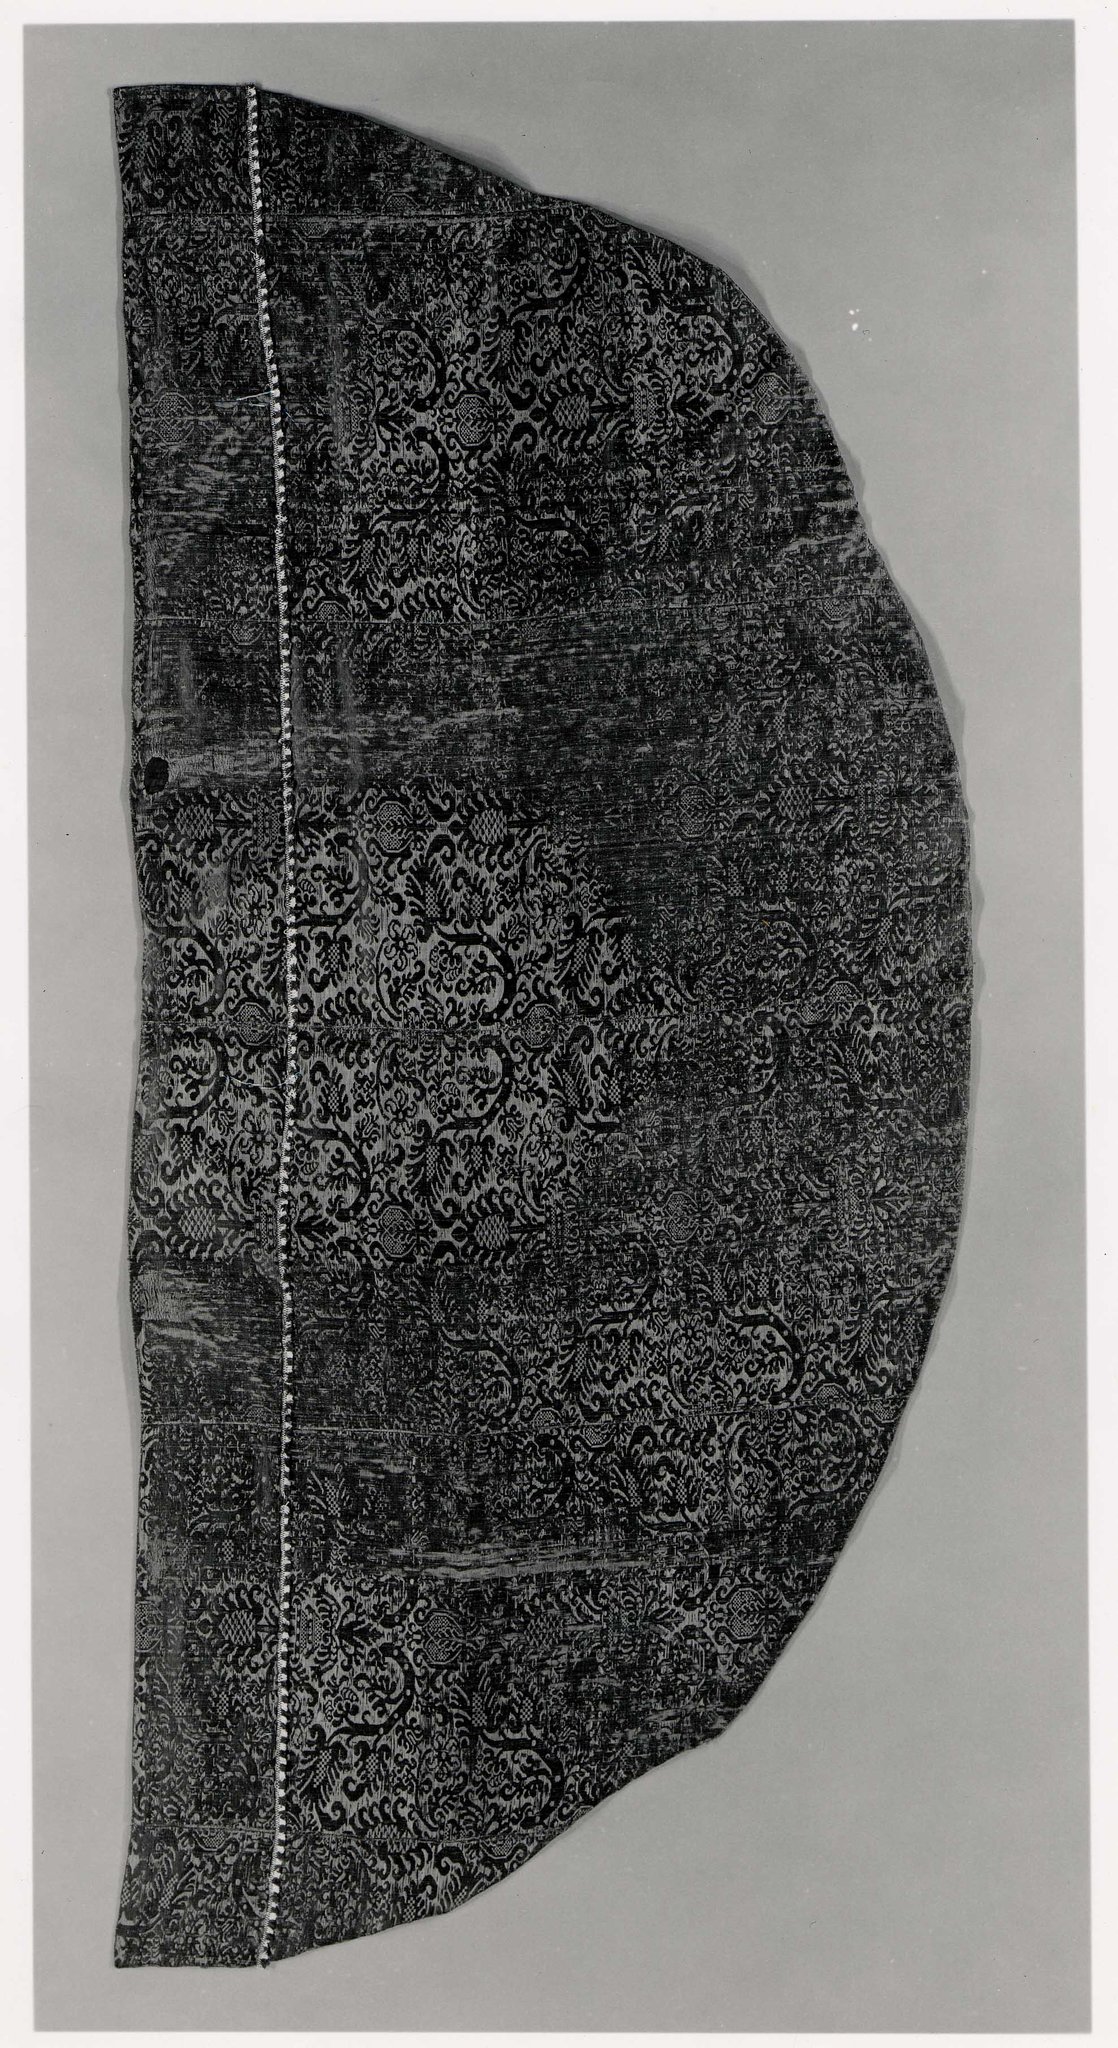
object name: cope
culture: italian or spanish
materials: linen, silk